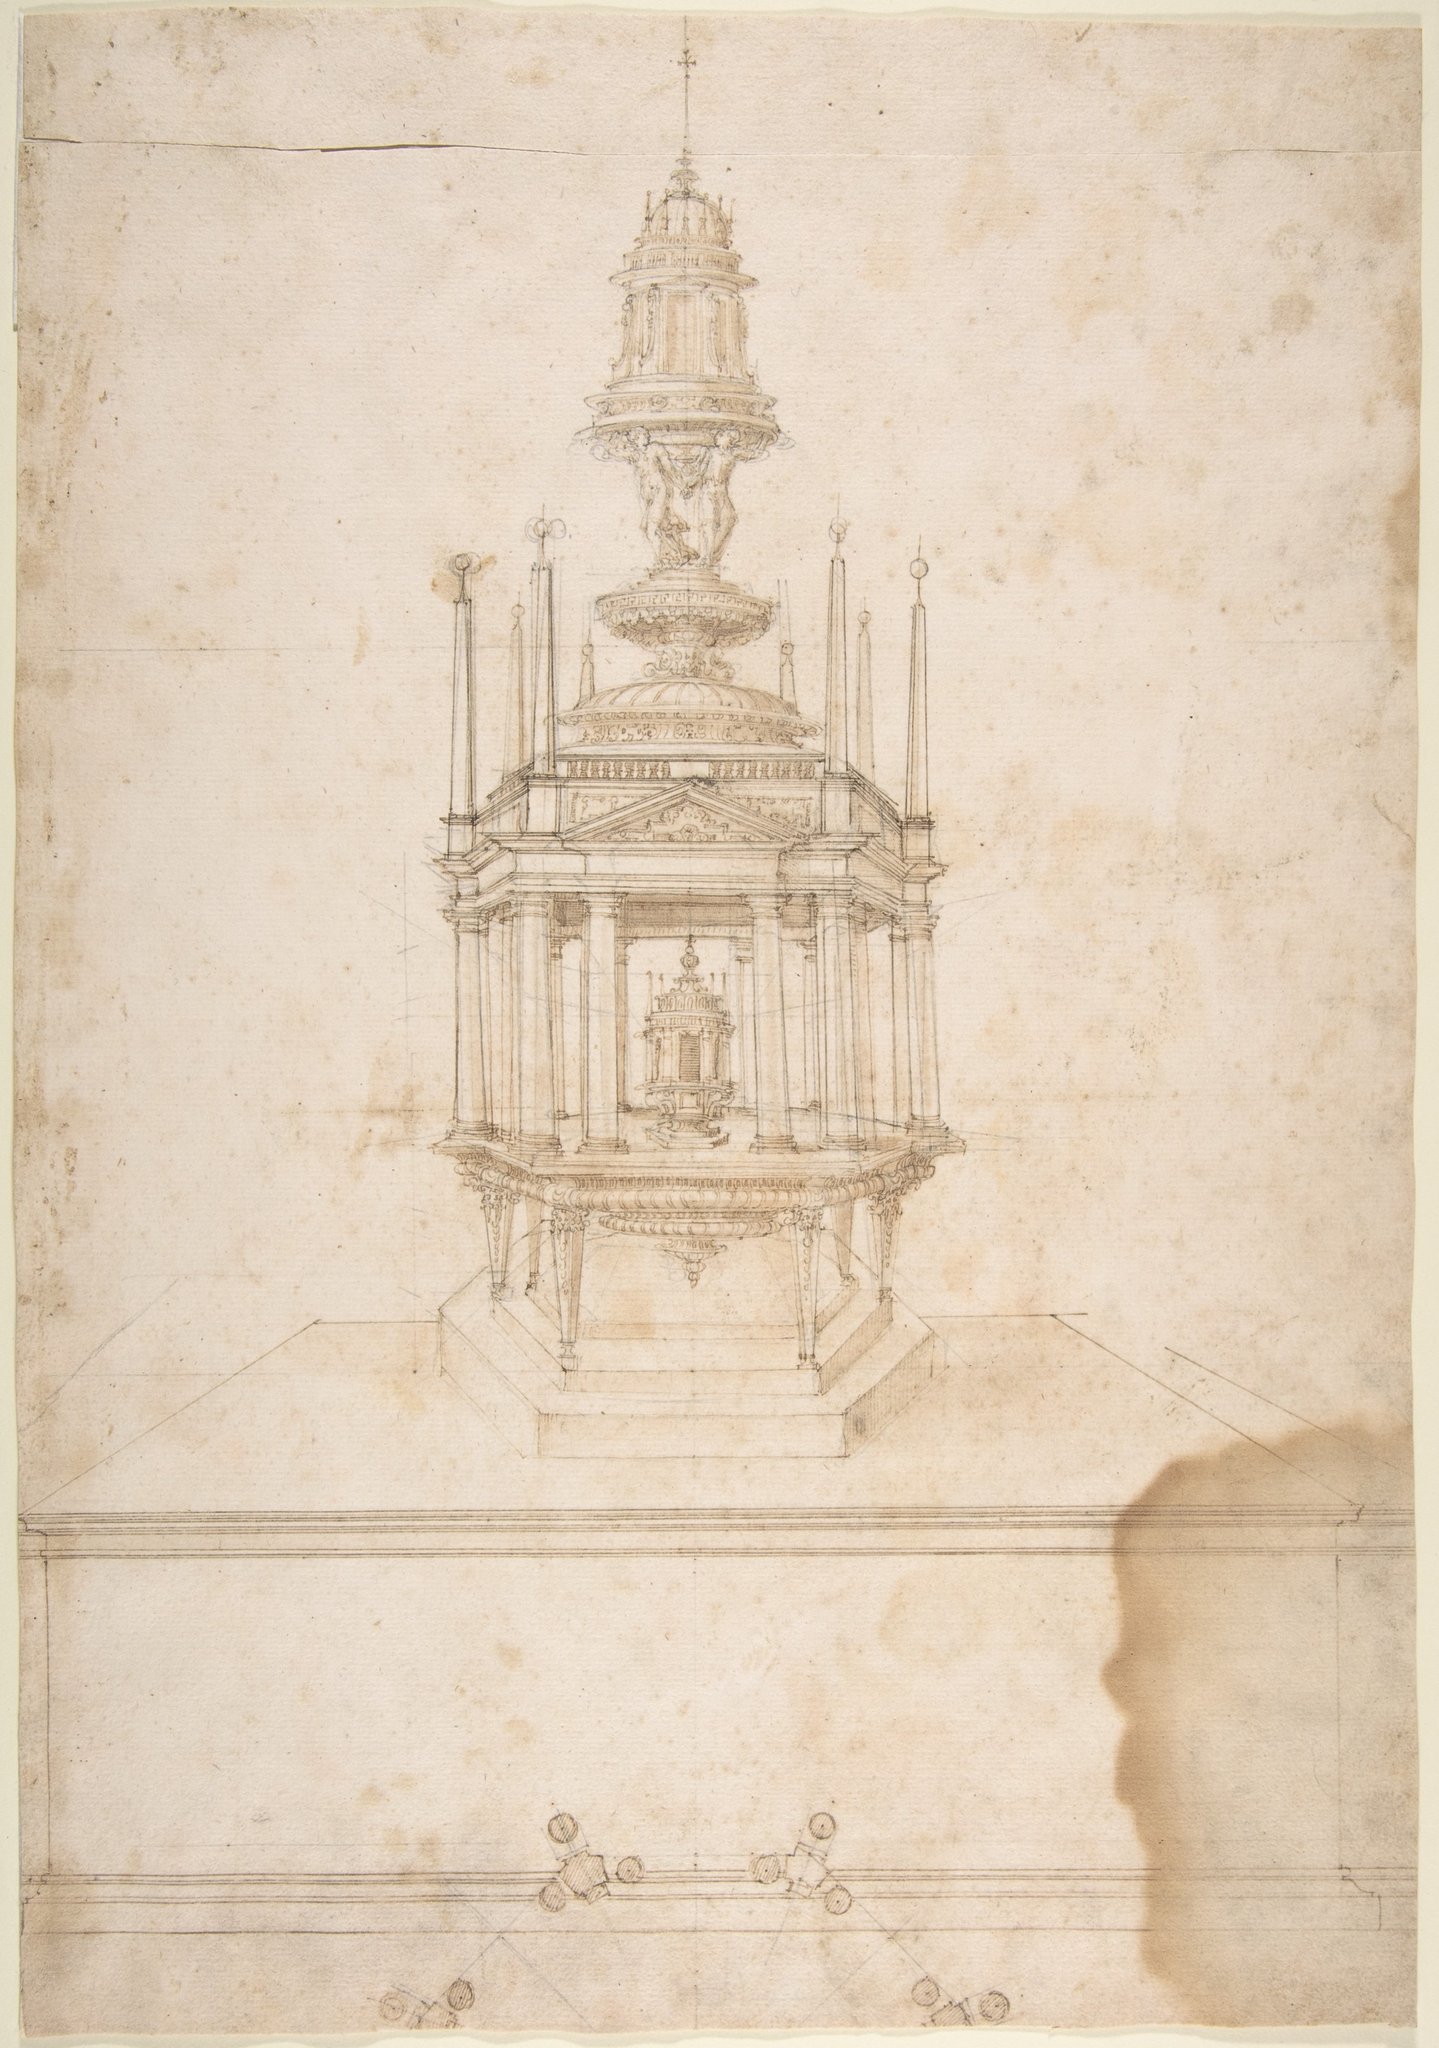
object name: drawing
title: Design for an Polygonal Tabernacle, with Obelisks and a Pediment Surmounted by Three Figures Supporting a Tempietto-like Structure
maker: galeazzo alessi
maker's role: artist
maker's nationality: italian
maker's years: 1512-1572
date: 1512-1572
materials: chalk, graphite, ink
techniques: brush, pen, wash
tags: tabernacles